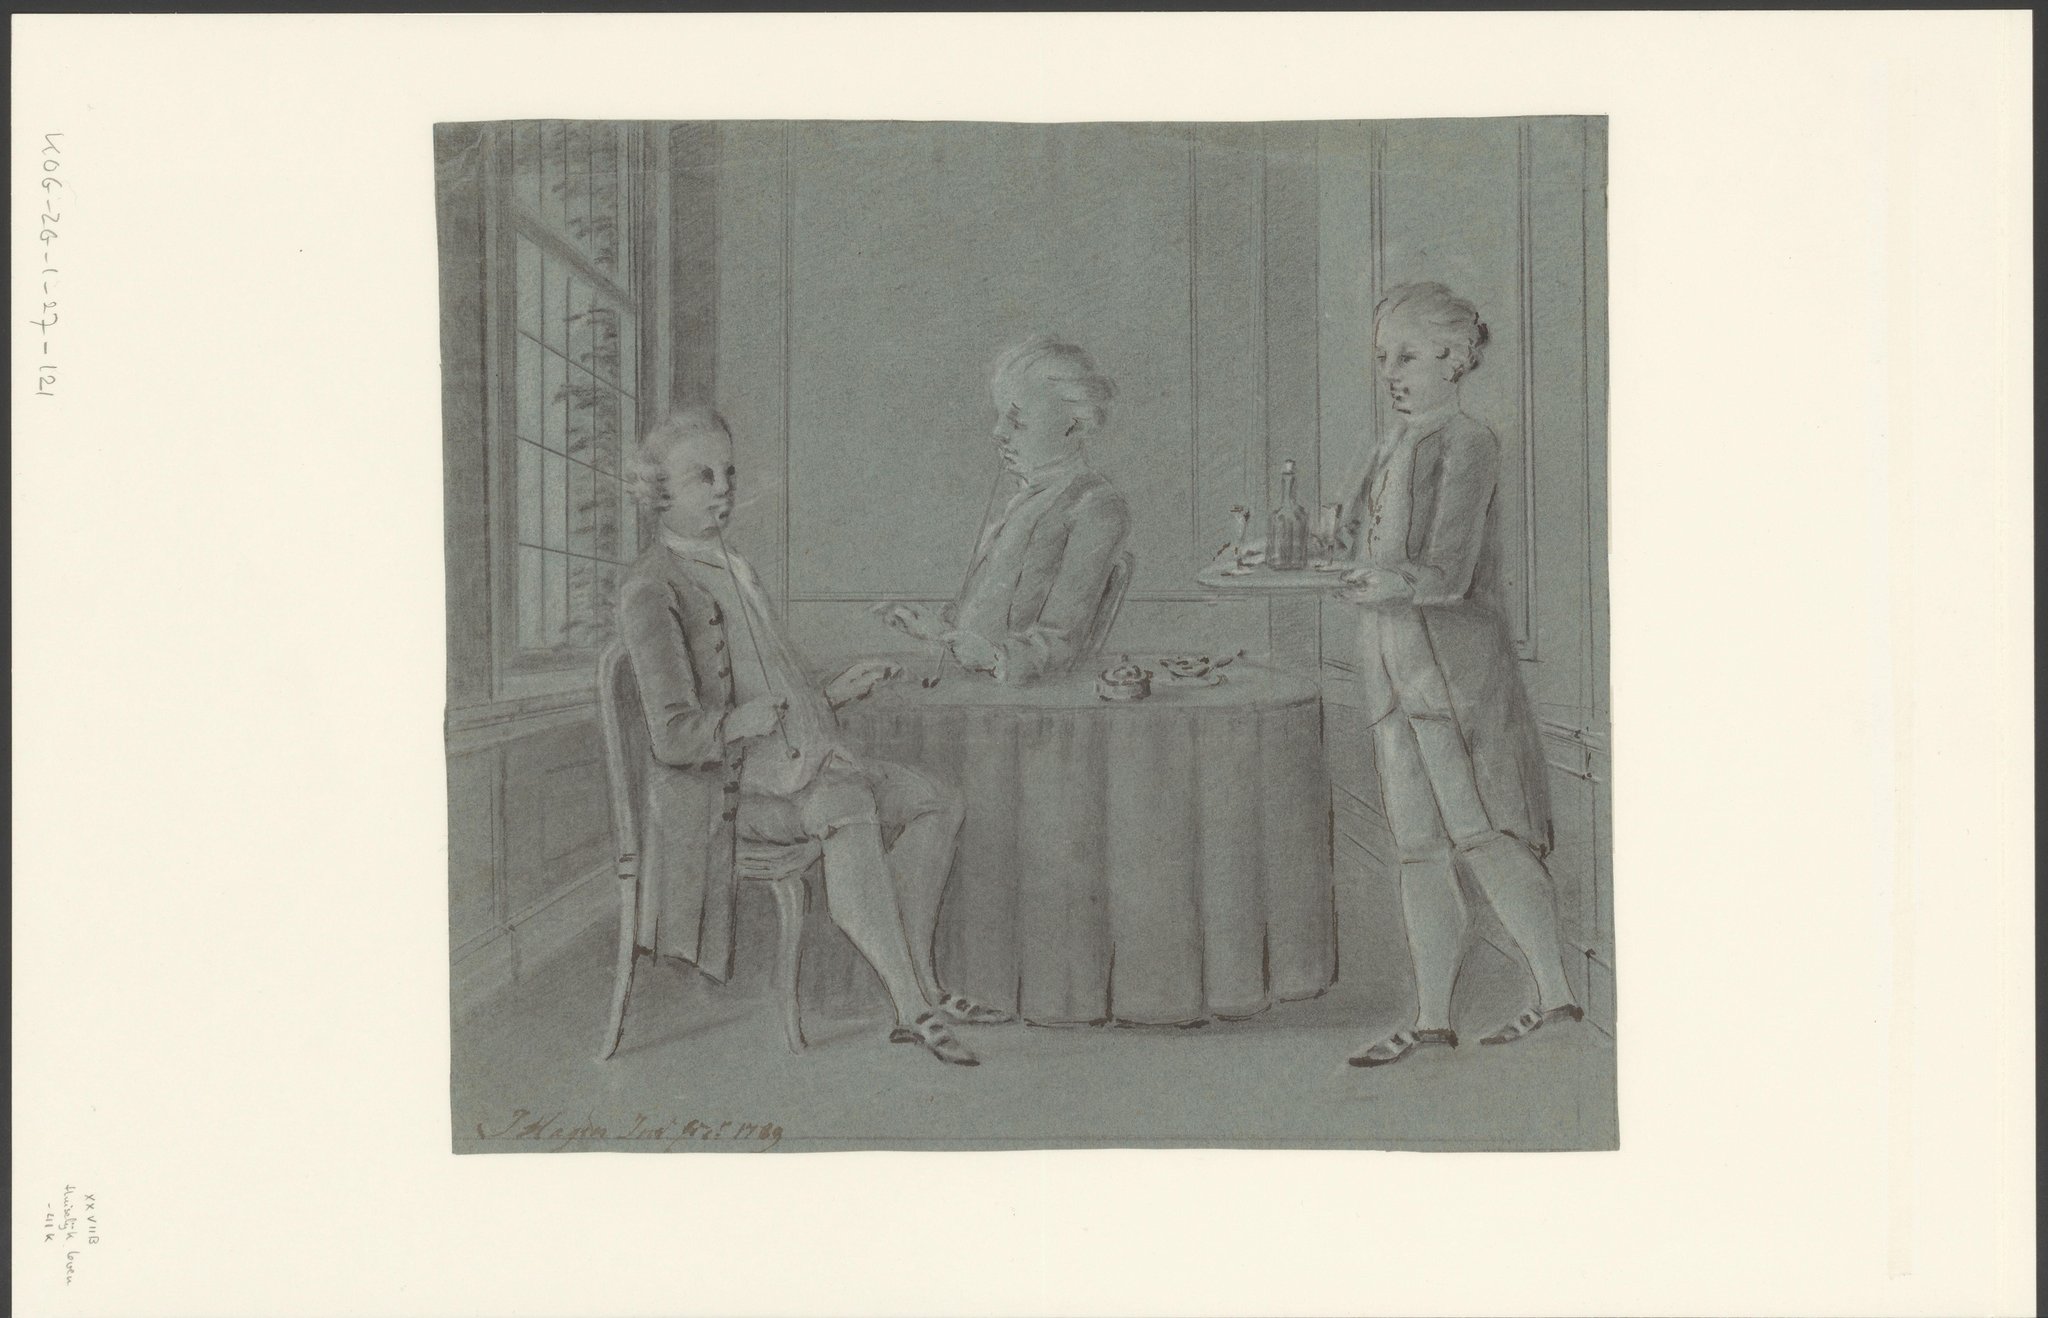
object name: drawing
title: Huiselijke taferelen door Jacob Hagen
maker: jacob hagen (ii)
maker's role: draughtsman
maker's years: 1703-1791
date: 1789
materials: chalk, ink, paper, pencil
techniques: brush, pen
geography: netherlands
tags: pipe ~ tobacco, communal rooms, house personnel, servants